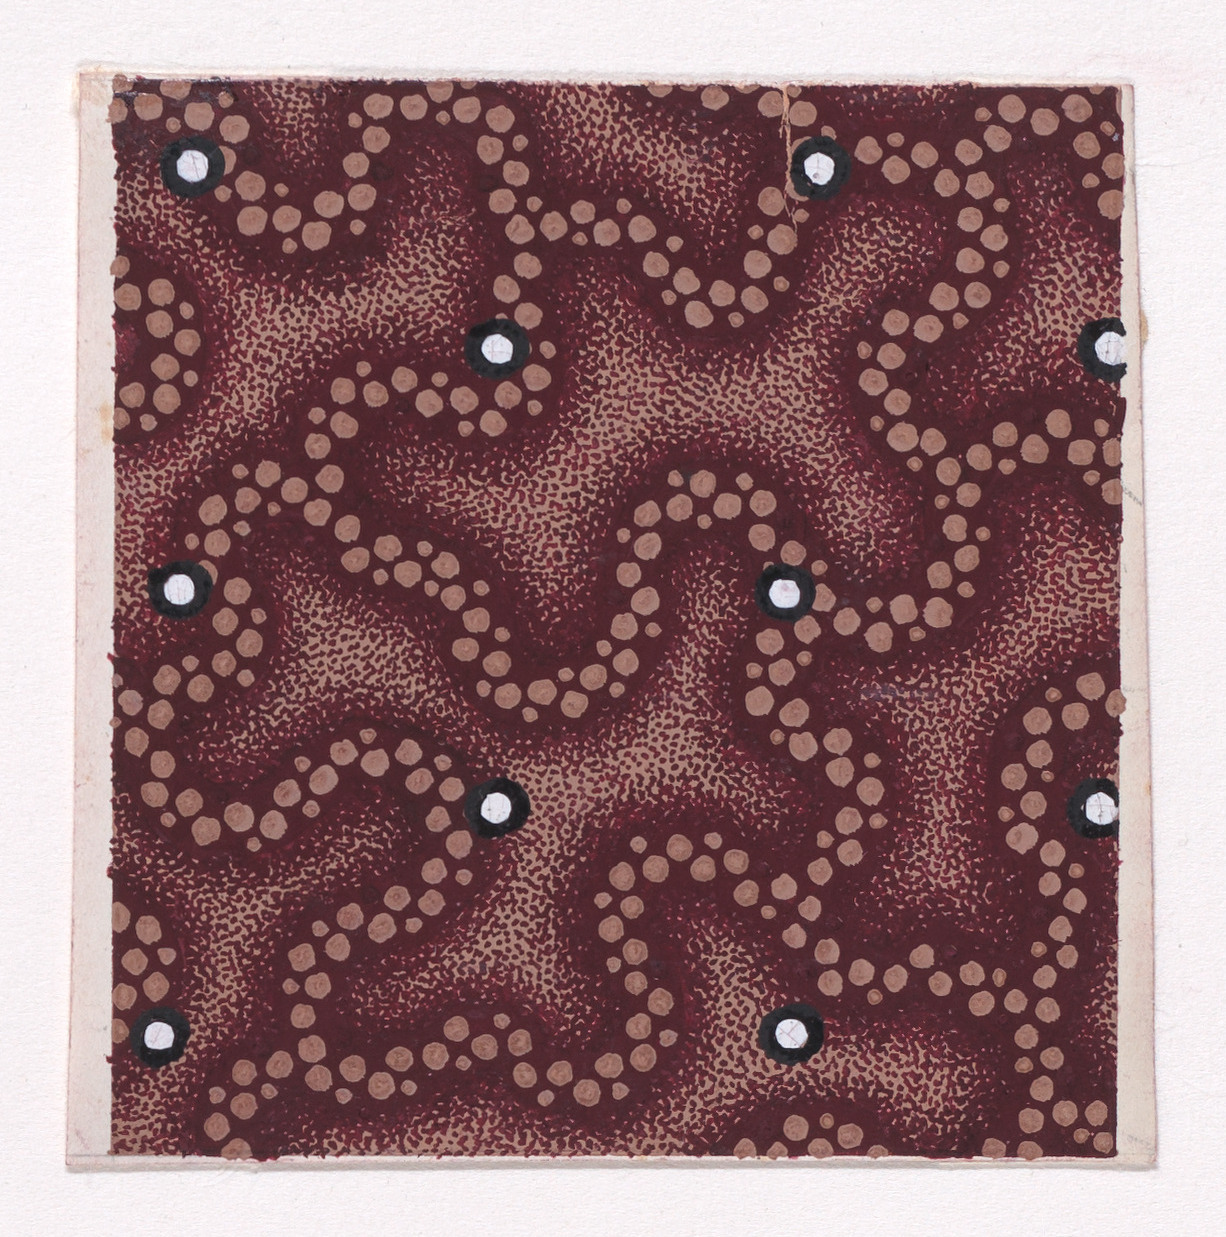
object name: drawing ornament architecture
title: Textile Design with Alternating Vertical and Horizontal Rows of Pearls Over a Vermicular Pattern Formed with Dotted Lines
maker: anonymous, alsatian, 19th century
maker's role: artist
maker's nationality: alsatian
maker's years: 1800-1900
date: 1840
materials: gouache